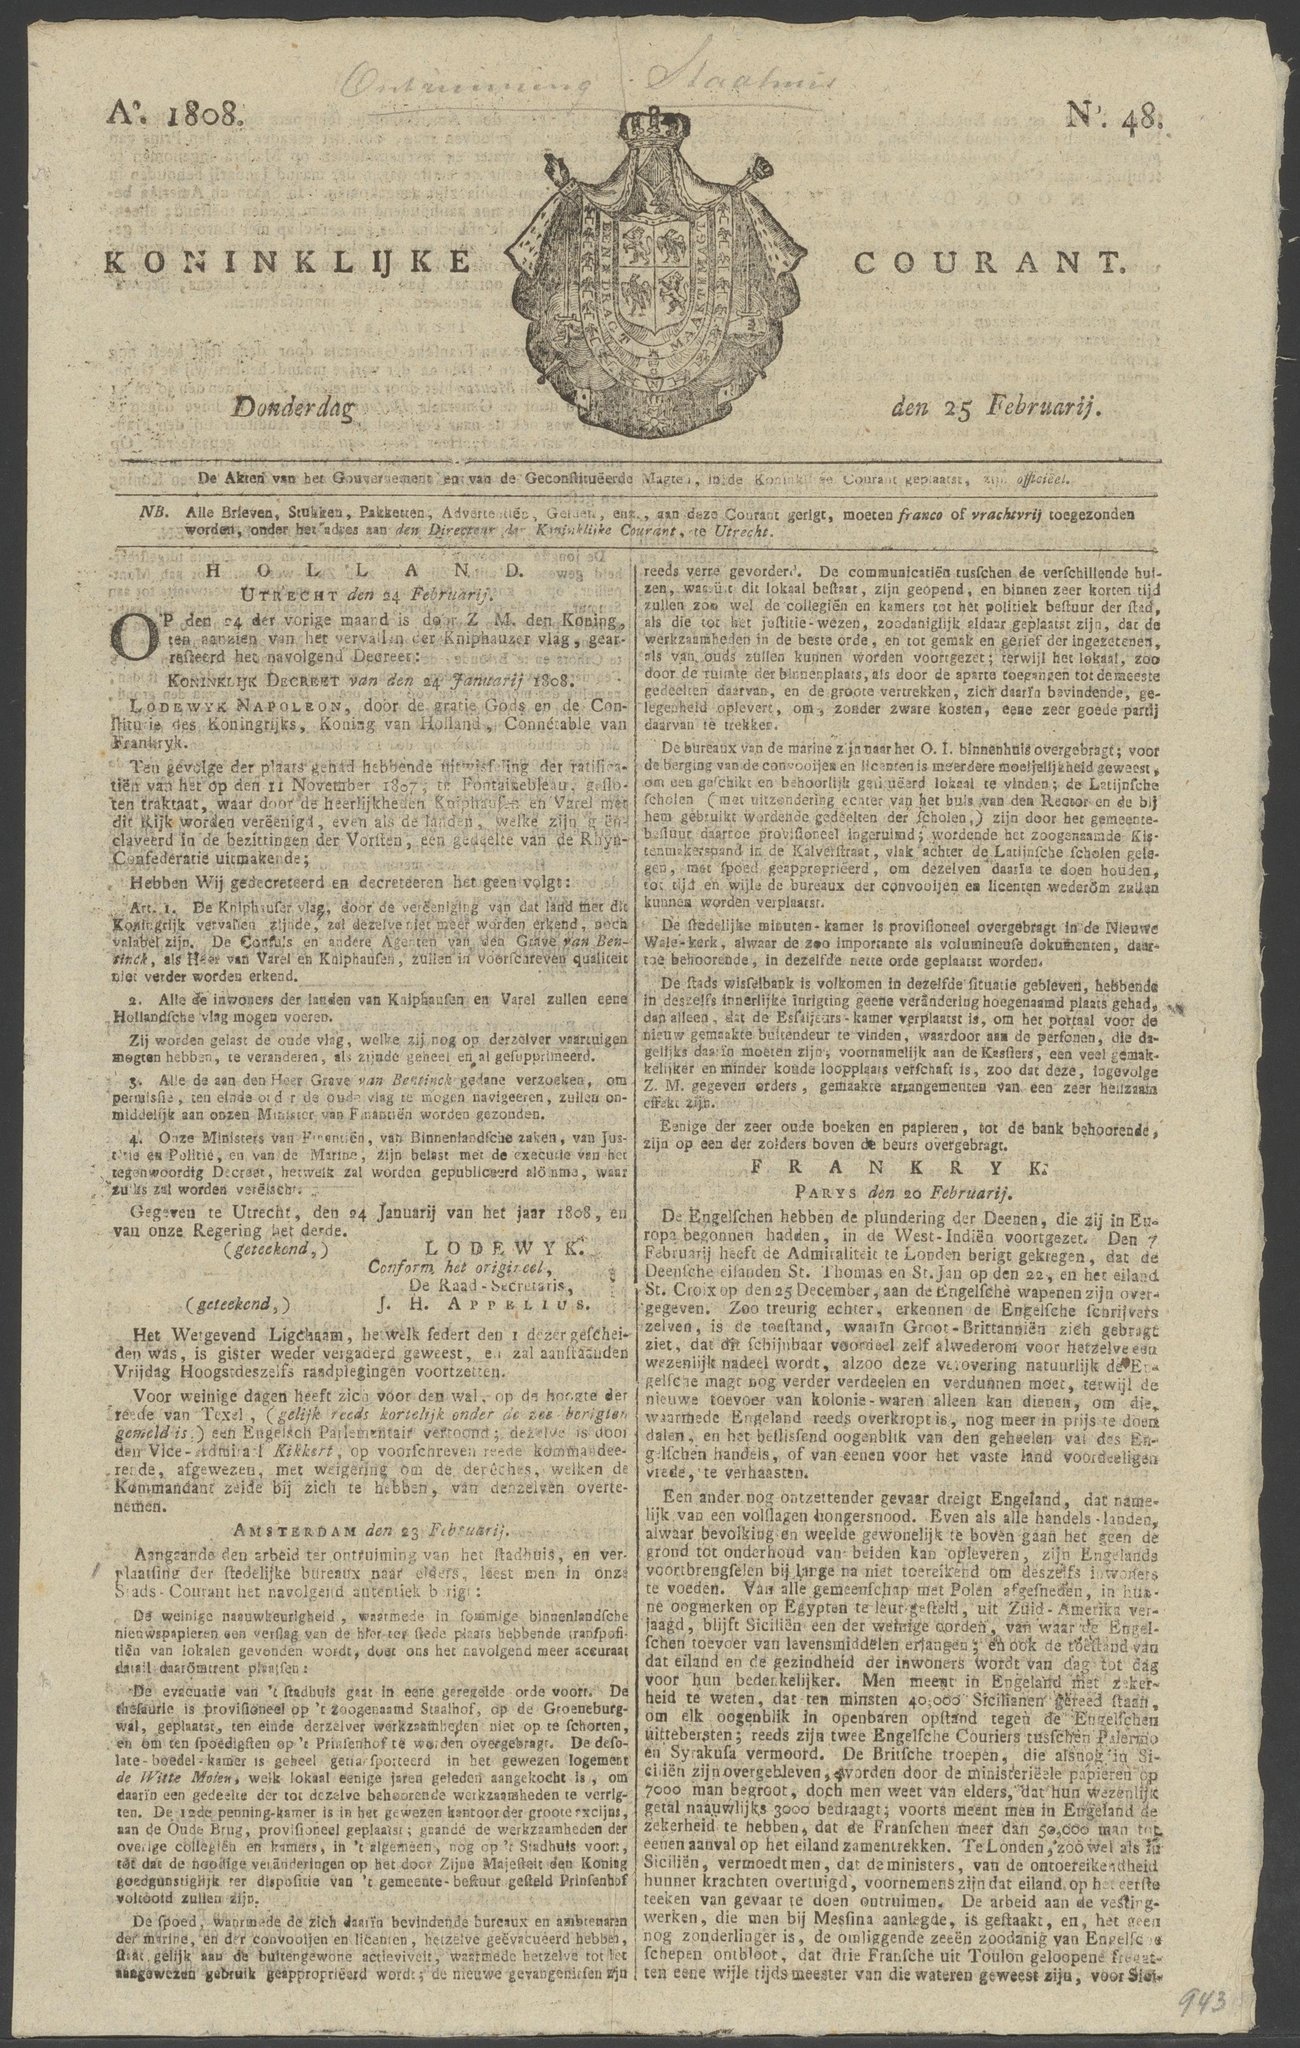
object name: newspaper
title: Koninklijke Courant, 25 februari 1808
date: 1808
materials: paper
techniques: letterpress printing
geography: utrecht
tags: newspaper, news-sheet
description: Exemplaar van de krant 'Koninklijke Courant', 25 februari 1808. Dubbelbladig, alle zijden bedrukt. Bovenaan een vignet met het wapen van het Koninkrijk Holland. Onderwerpsrubrieken binnen de Atlas Zeden en Gewoonten: Regeering, Officieele Nieuwsbladen.